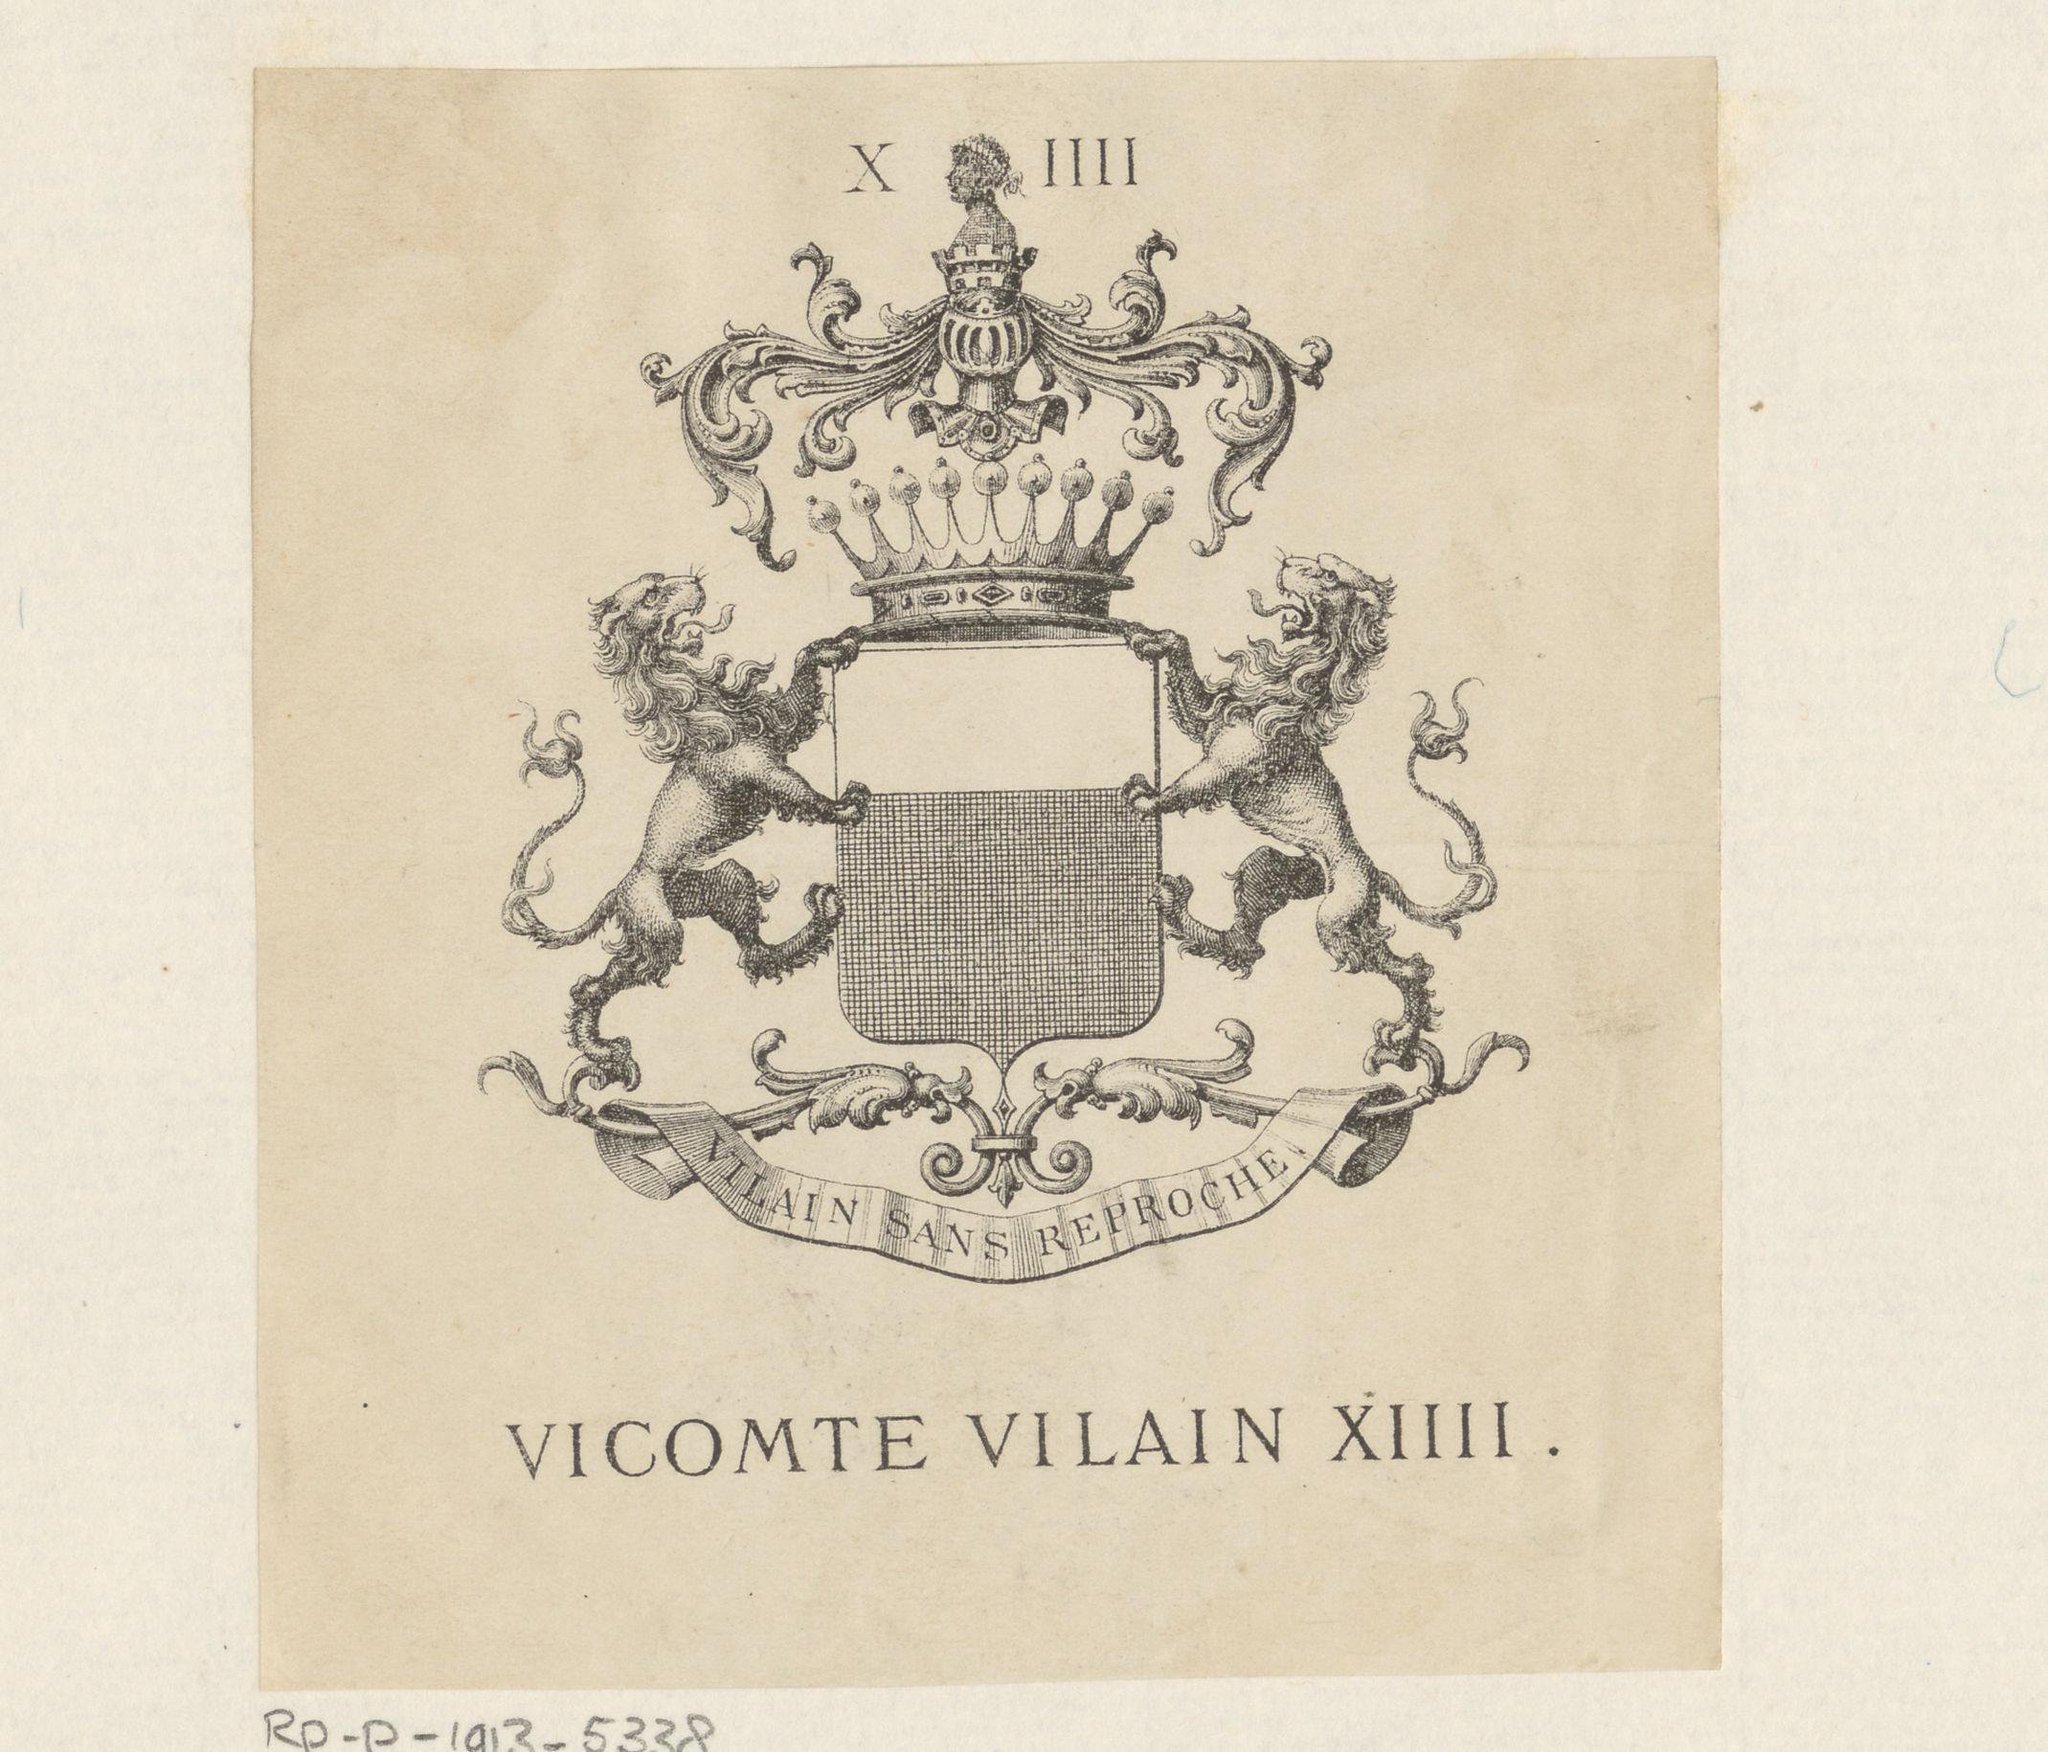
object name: bookplate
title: Vilain sans reproche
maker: Anonymous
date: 1800-1899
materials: paper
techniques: etching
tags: armorial bearing, heraldry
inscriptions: collector's mark: Lugt 2233, collector's mark: Lugt 2760